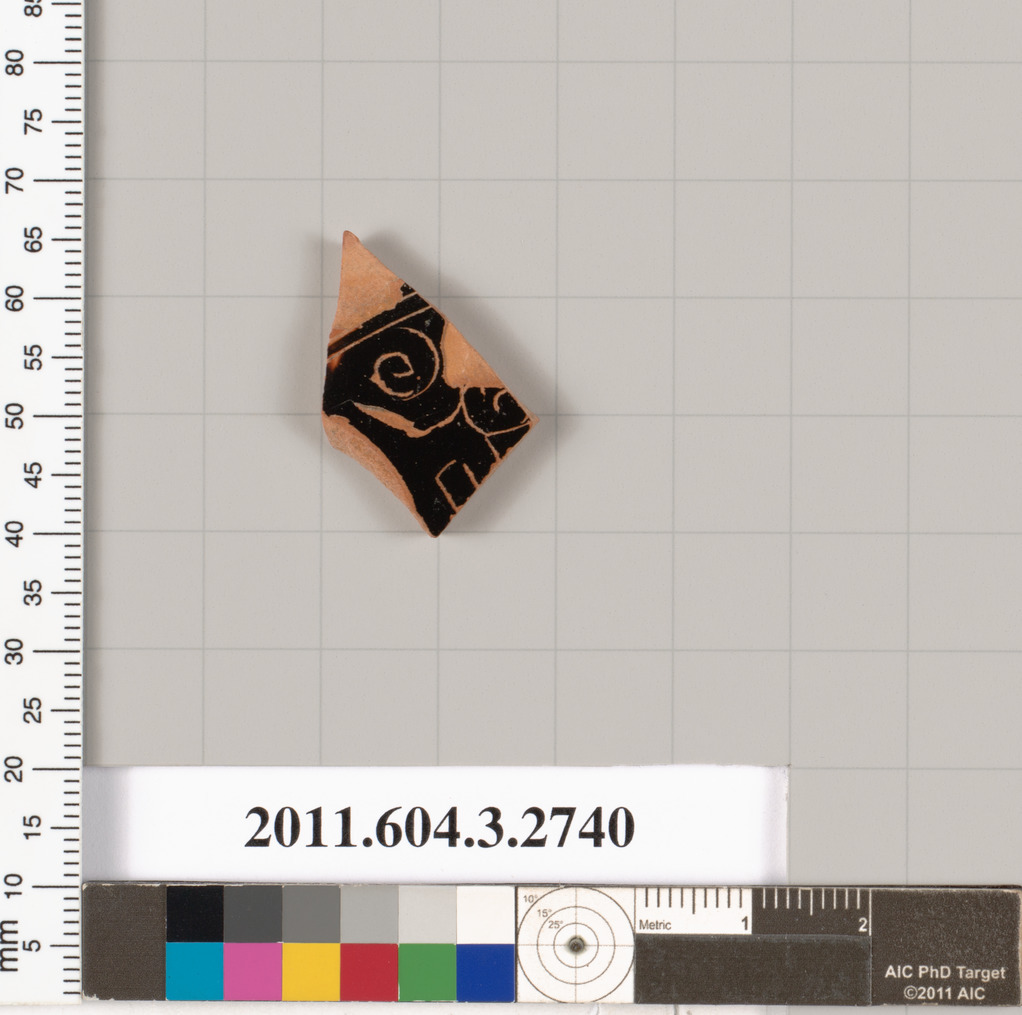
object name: olpe fragment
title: Terracotta fragment of an olpe (jug)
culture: greek, attic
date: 534-468 BCE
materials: terracotta